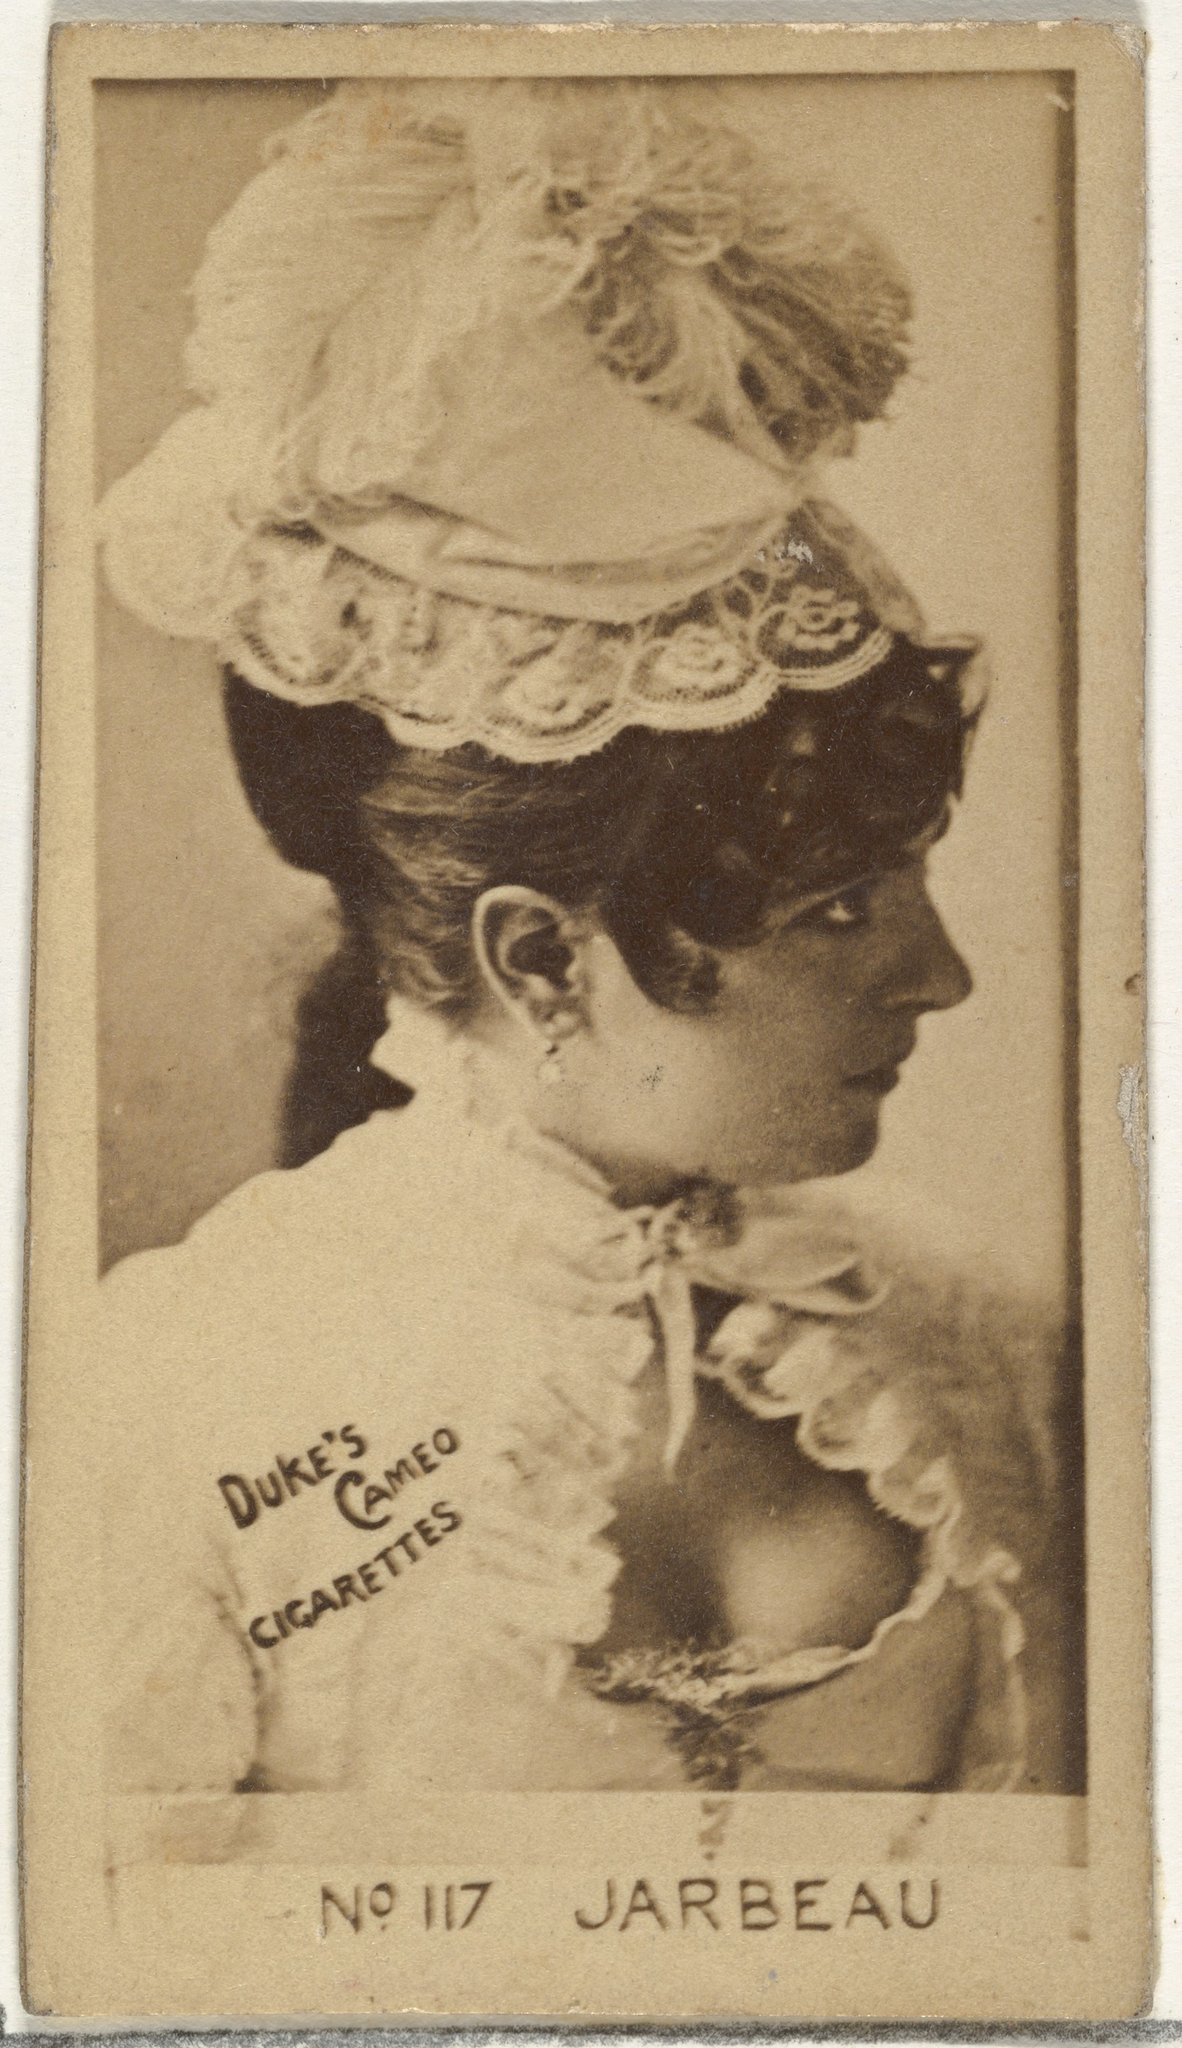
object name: photograph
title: Card Number 117, Vernona Jarbeau, from the Actors and Actresses series (N145-4) issued by Duke Sons & Co. to promote Cameo Cigarettes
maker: w. duke, sons & co.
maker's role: publisher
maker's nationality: american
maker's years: 1870-1920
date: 1880-1889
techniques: albumen silver print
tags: women,actresses